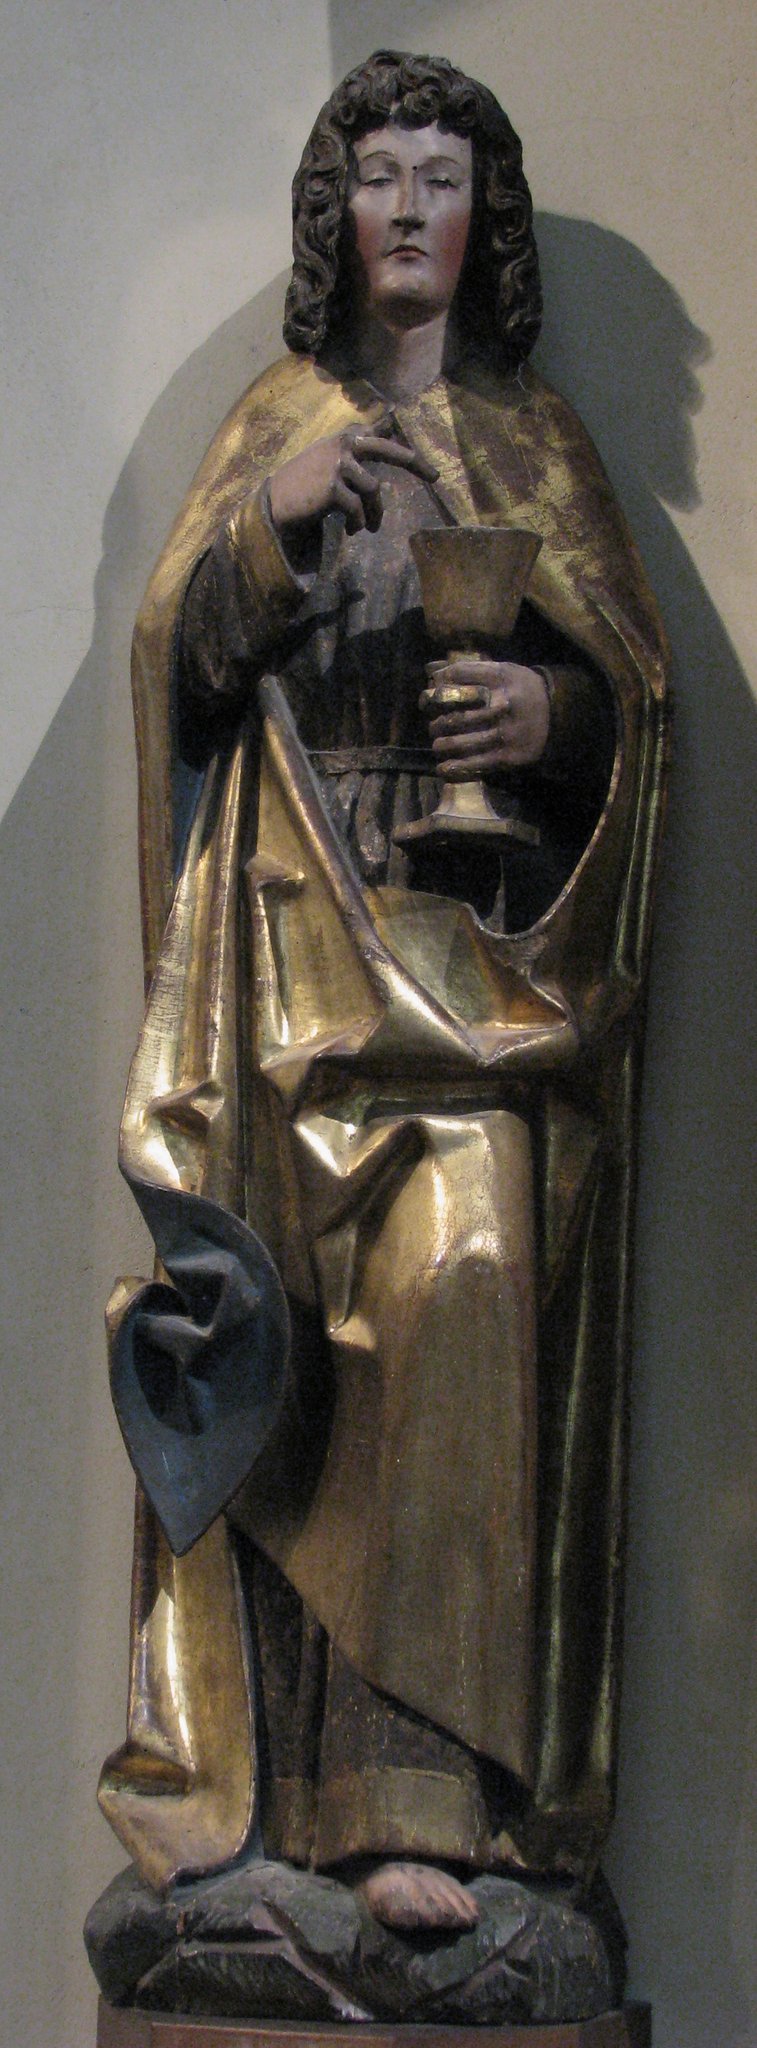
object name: statue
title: Saint John the Evangelist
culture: german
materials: wood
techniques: gilding, painting